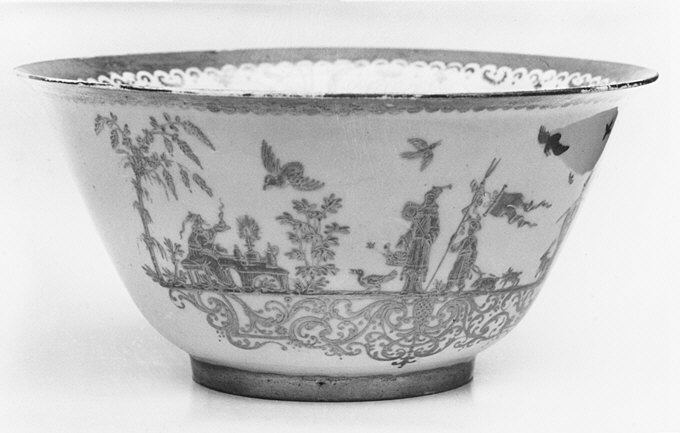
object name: bowl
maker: meissen manufactory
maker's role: manufactory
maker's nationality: german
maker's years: 1710-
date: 1720-1725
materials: hard paste porcelain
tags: human figures,birds,trees